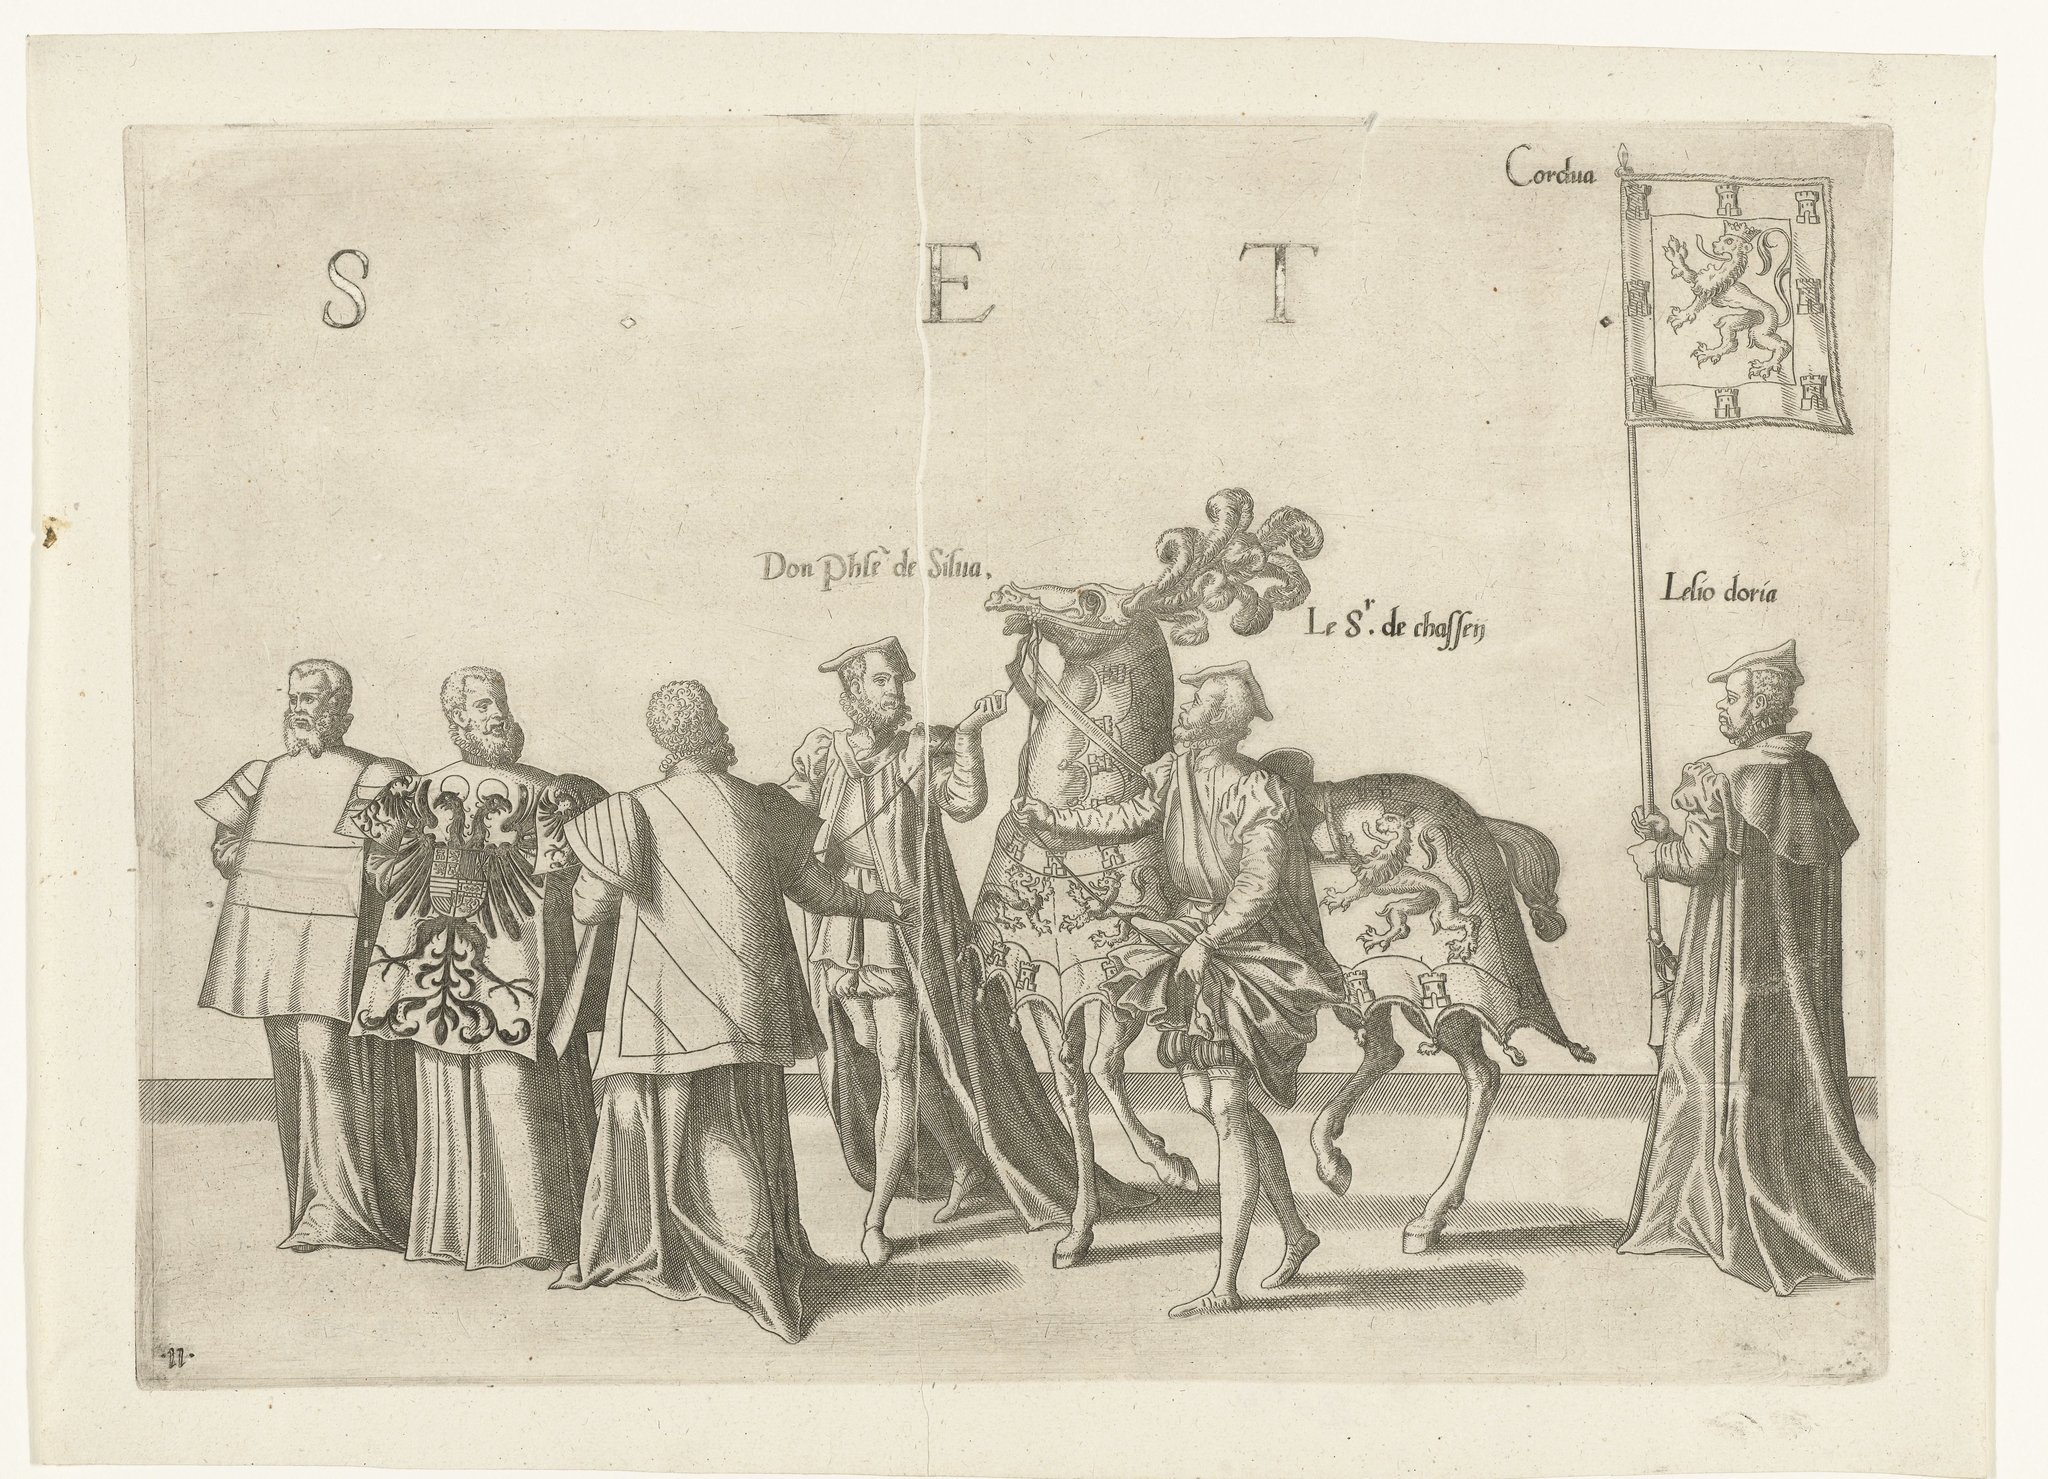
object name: print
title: Deel van de optocht, nr. 11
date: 1559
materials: paper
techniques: engraving, etching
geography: southern netherlands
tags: ghent, charles v (holy roman emperor and king of spain), cortege, funeral procession, brussels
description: Zes deelnemers aan de optocht, een paard en het vaandel met het wapen van Cordova. Onderdeel van de prentreeks van de Begrafenisoptocht van keizer Karel V op 29 december 1558 te Brussel.